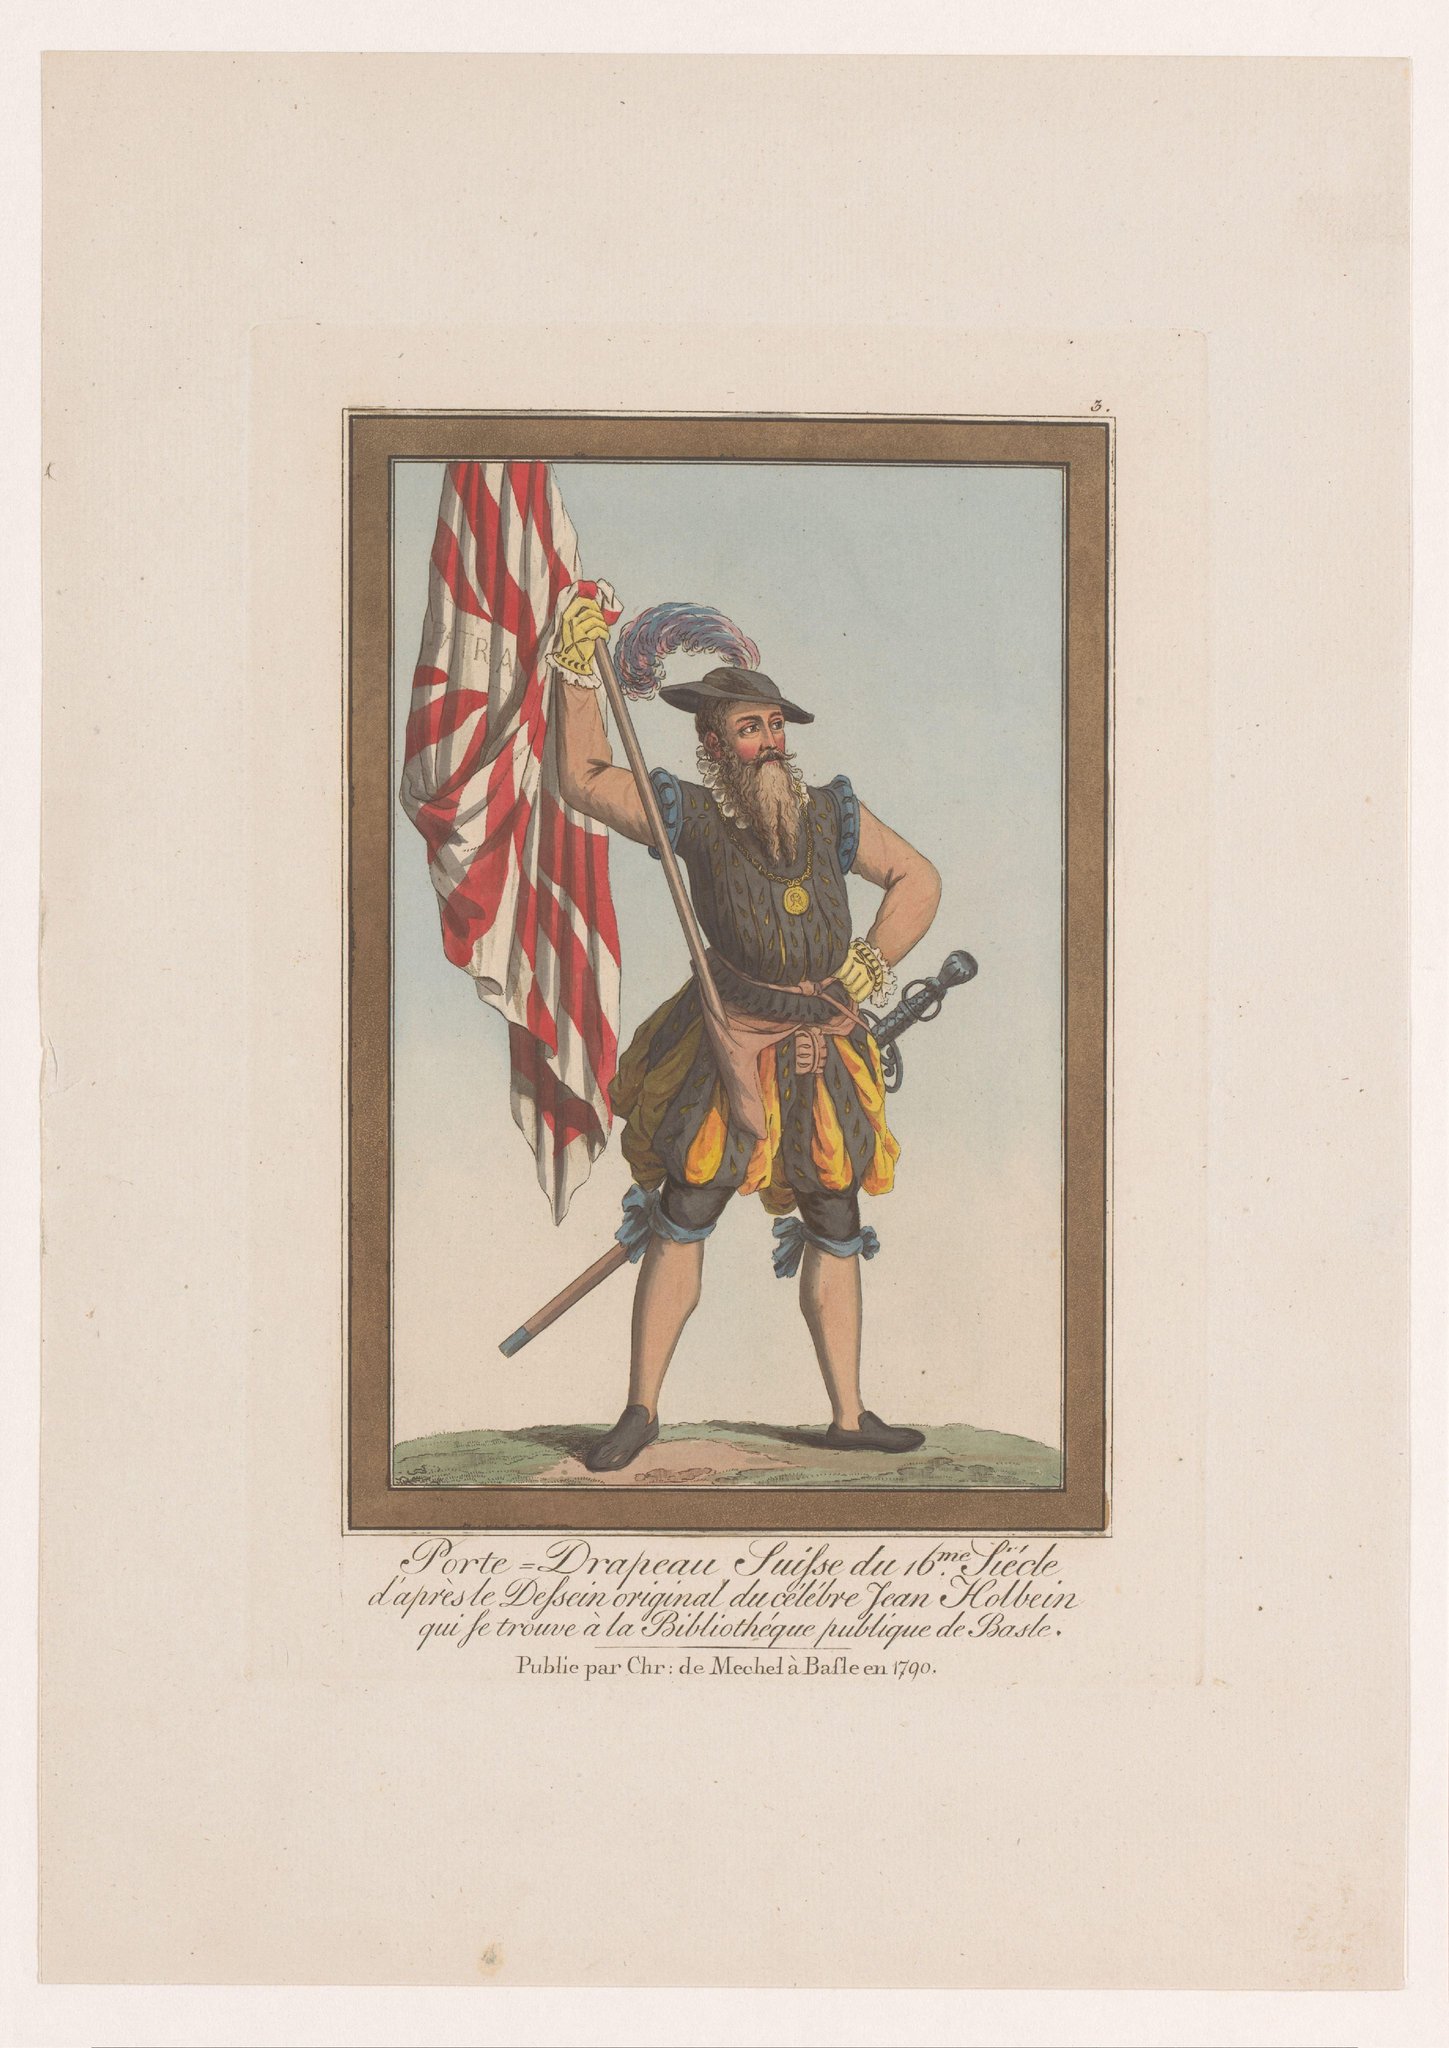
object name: print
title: Recueil de XII costumes Suisses civils et militaires, hommes et femmes, du seizième siècle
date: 1790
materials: paper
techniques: aquatint, etching, hand coloring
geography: basel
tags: (military) uniforms (+ weapons), hacking and thrusting weapons: sword, (military) standard-bearer, medals and other marks of military honour, clothes, costume, beard, (military) flags and standards, switzerland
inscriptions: collector's mark: Lugt 2228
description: De serie behoort tot de 4-delige publicatie 'Oeuvre de Jean Holbein', Bazel 1780-1795, door Christian von Mechel.